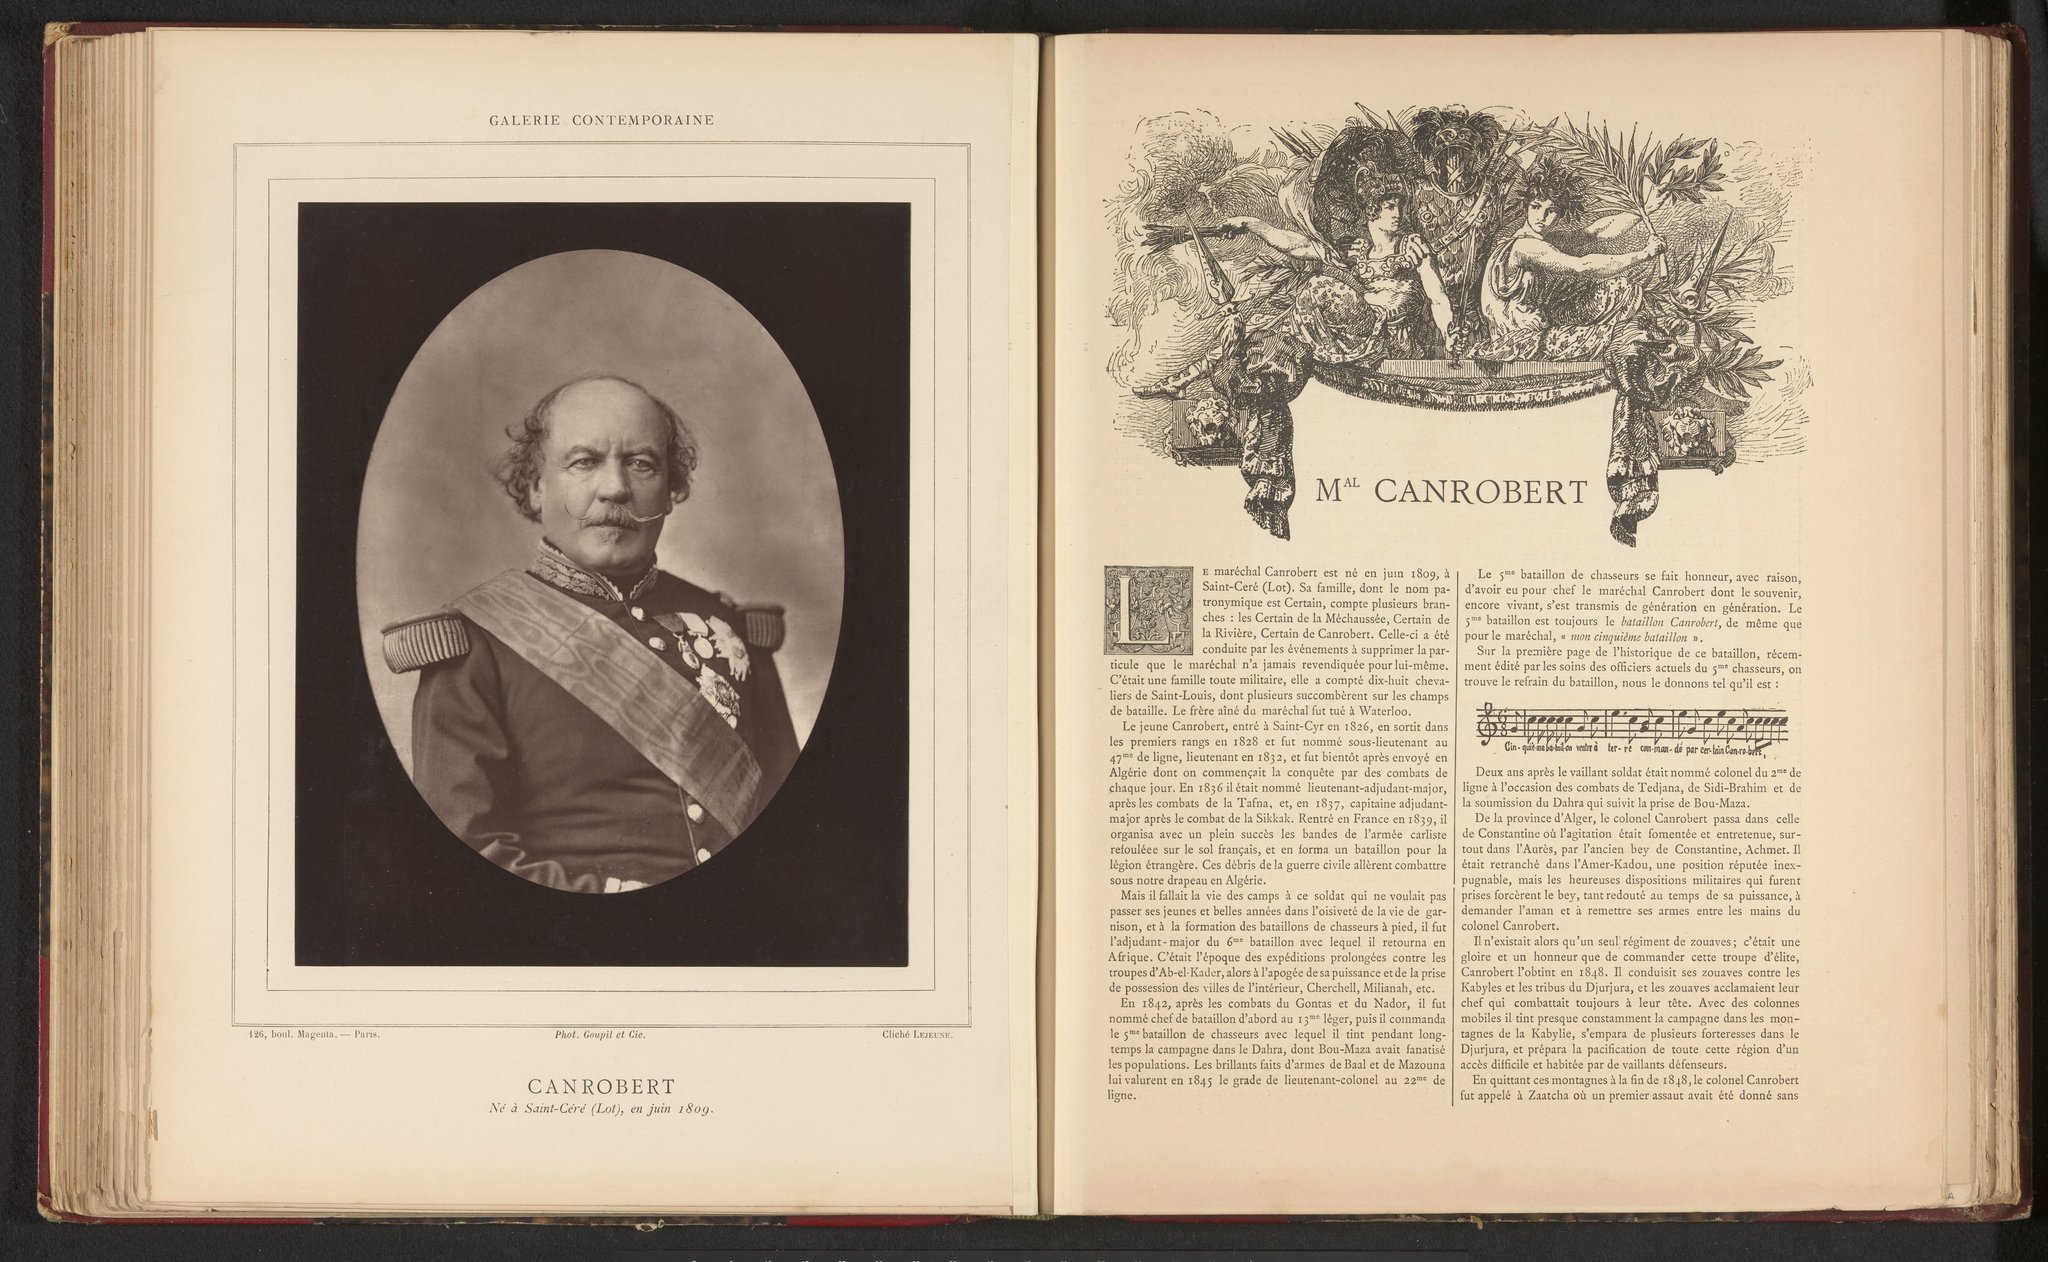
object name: page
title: Portret van François Certain Canrobert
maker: augustin aimé joseph lejeune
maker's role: fotograaf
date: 1876-1879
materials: paper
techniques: woodburytype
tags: paris, commander-in-chief, general, marshal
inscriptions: inscription: ‘126, boul. Magenta.-Paris.’